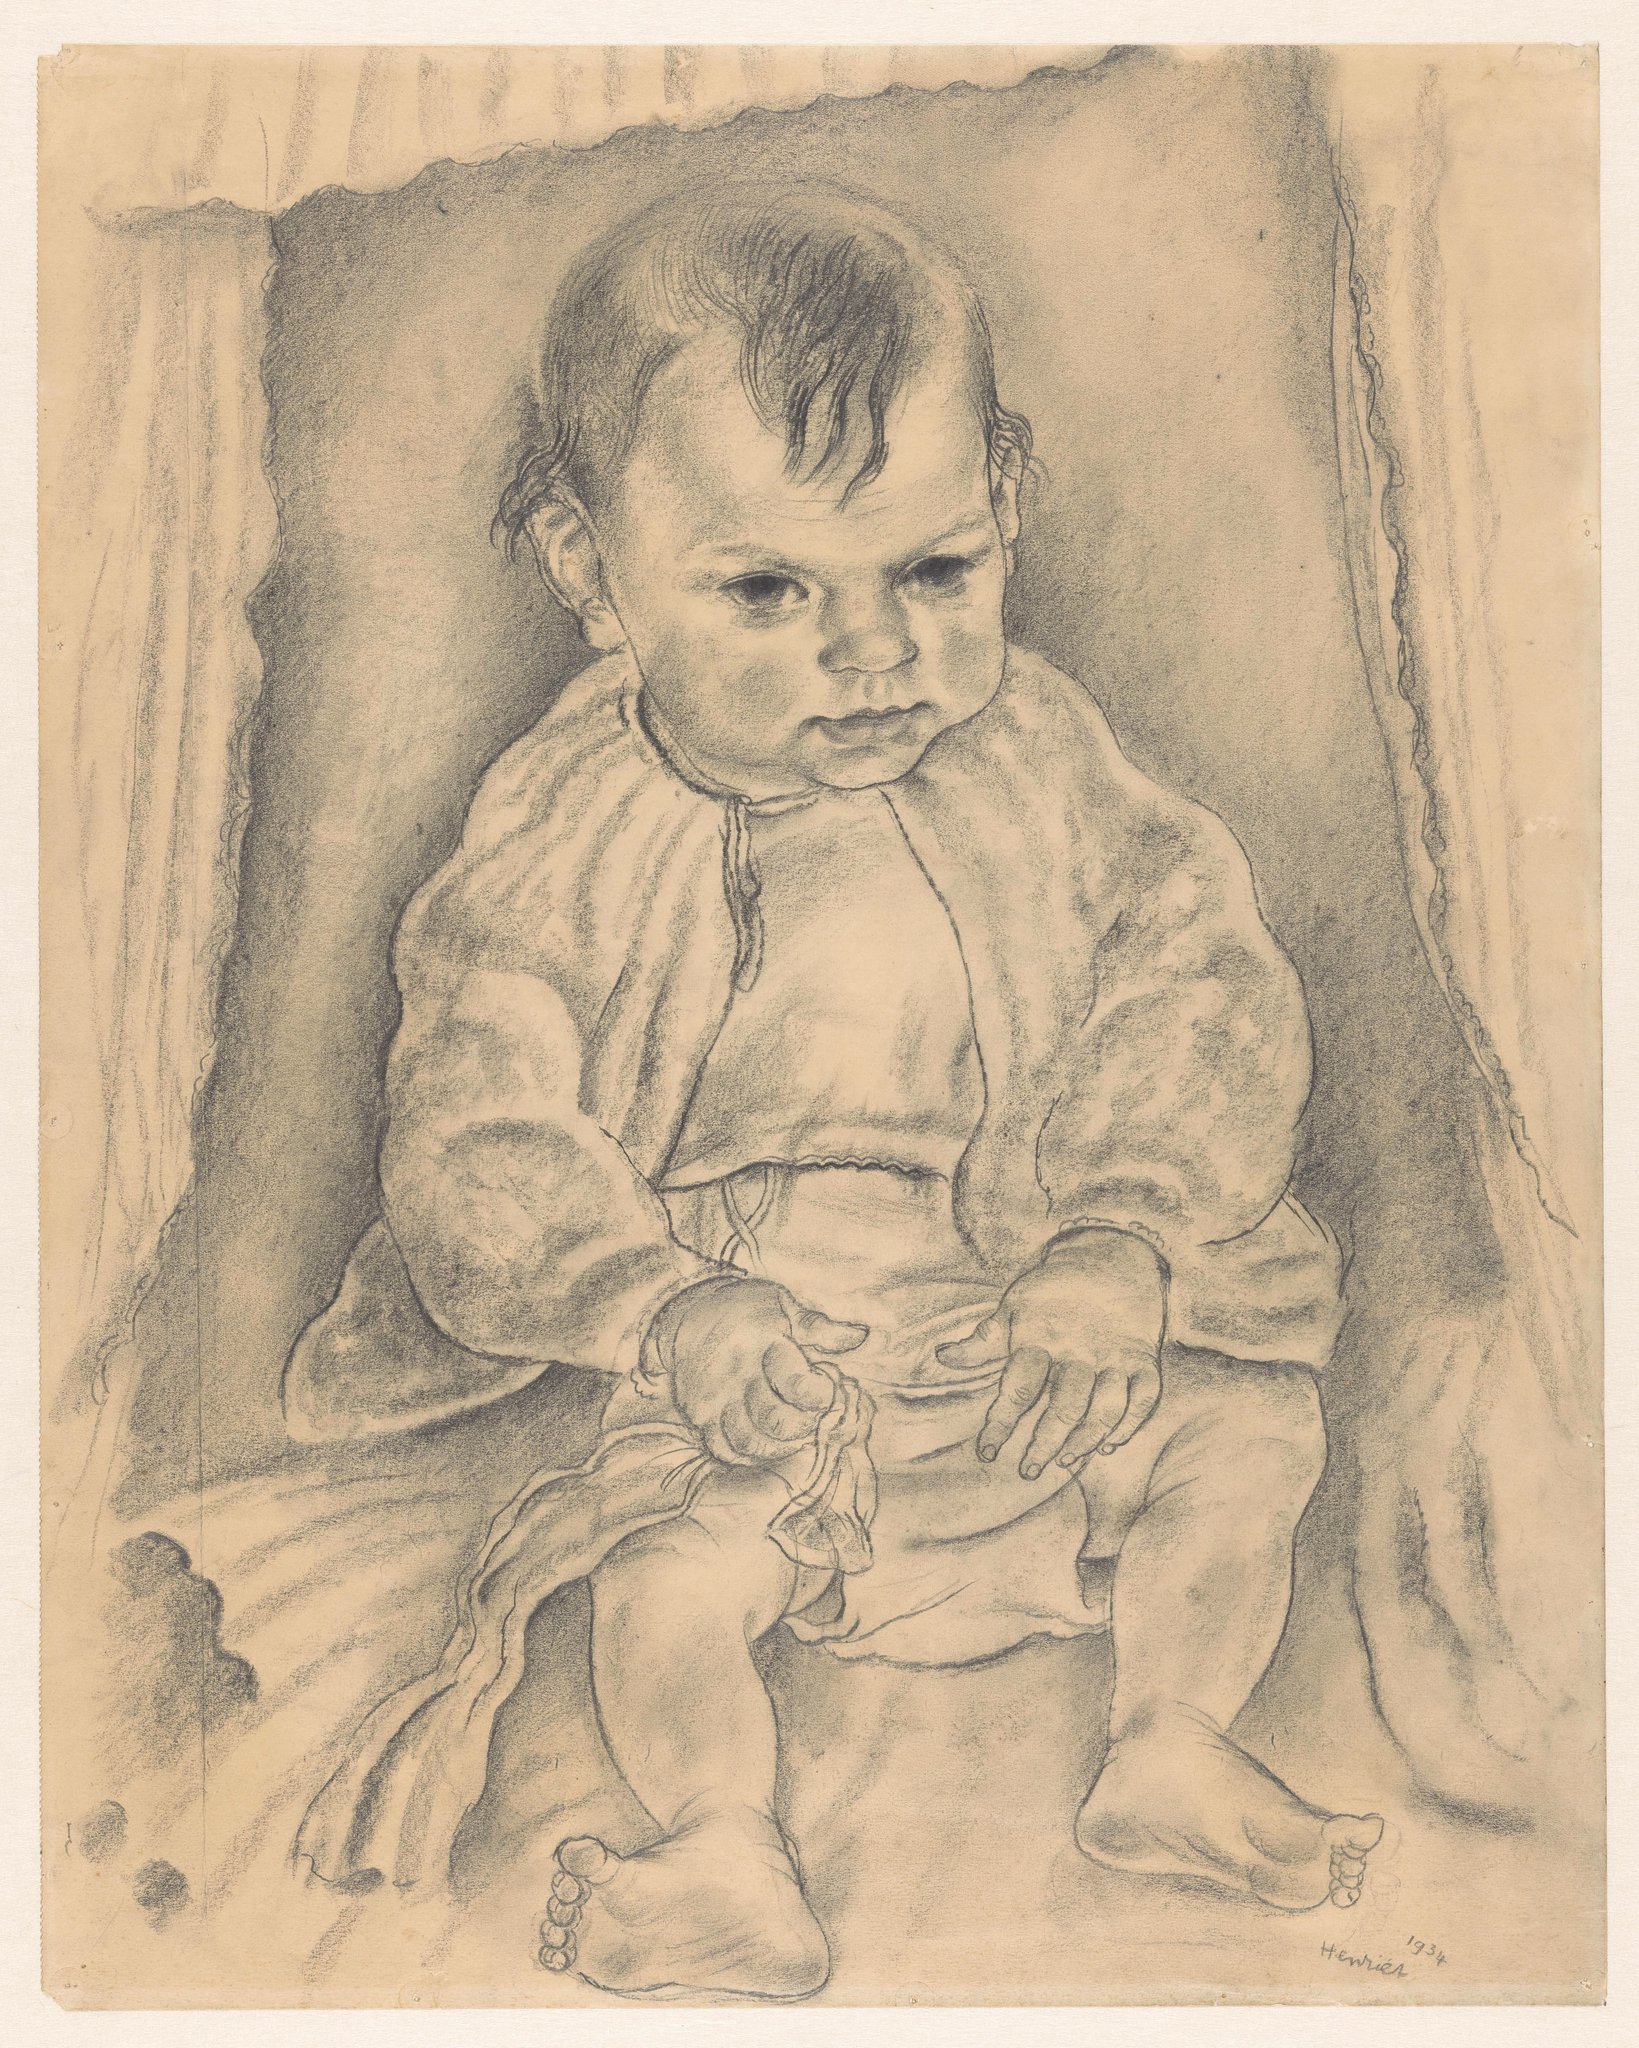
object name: drawing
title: Zittende baby met een lap in de hand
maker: henk henriët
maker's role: draughtsman, print maker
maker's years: 1903-1945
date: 1934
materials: paper, pencil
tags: infant, baby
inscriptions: inscription: ‘28’, collector's mark: Lugt 2228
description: Deze tekening is mogelijk een portret van een kind van de kunstenaar.